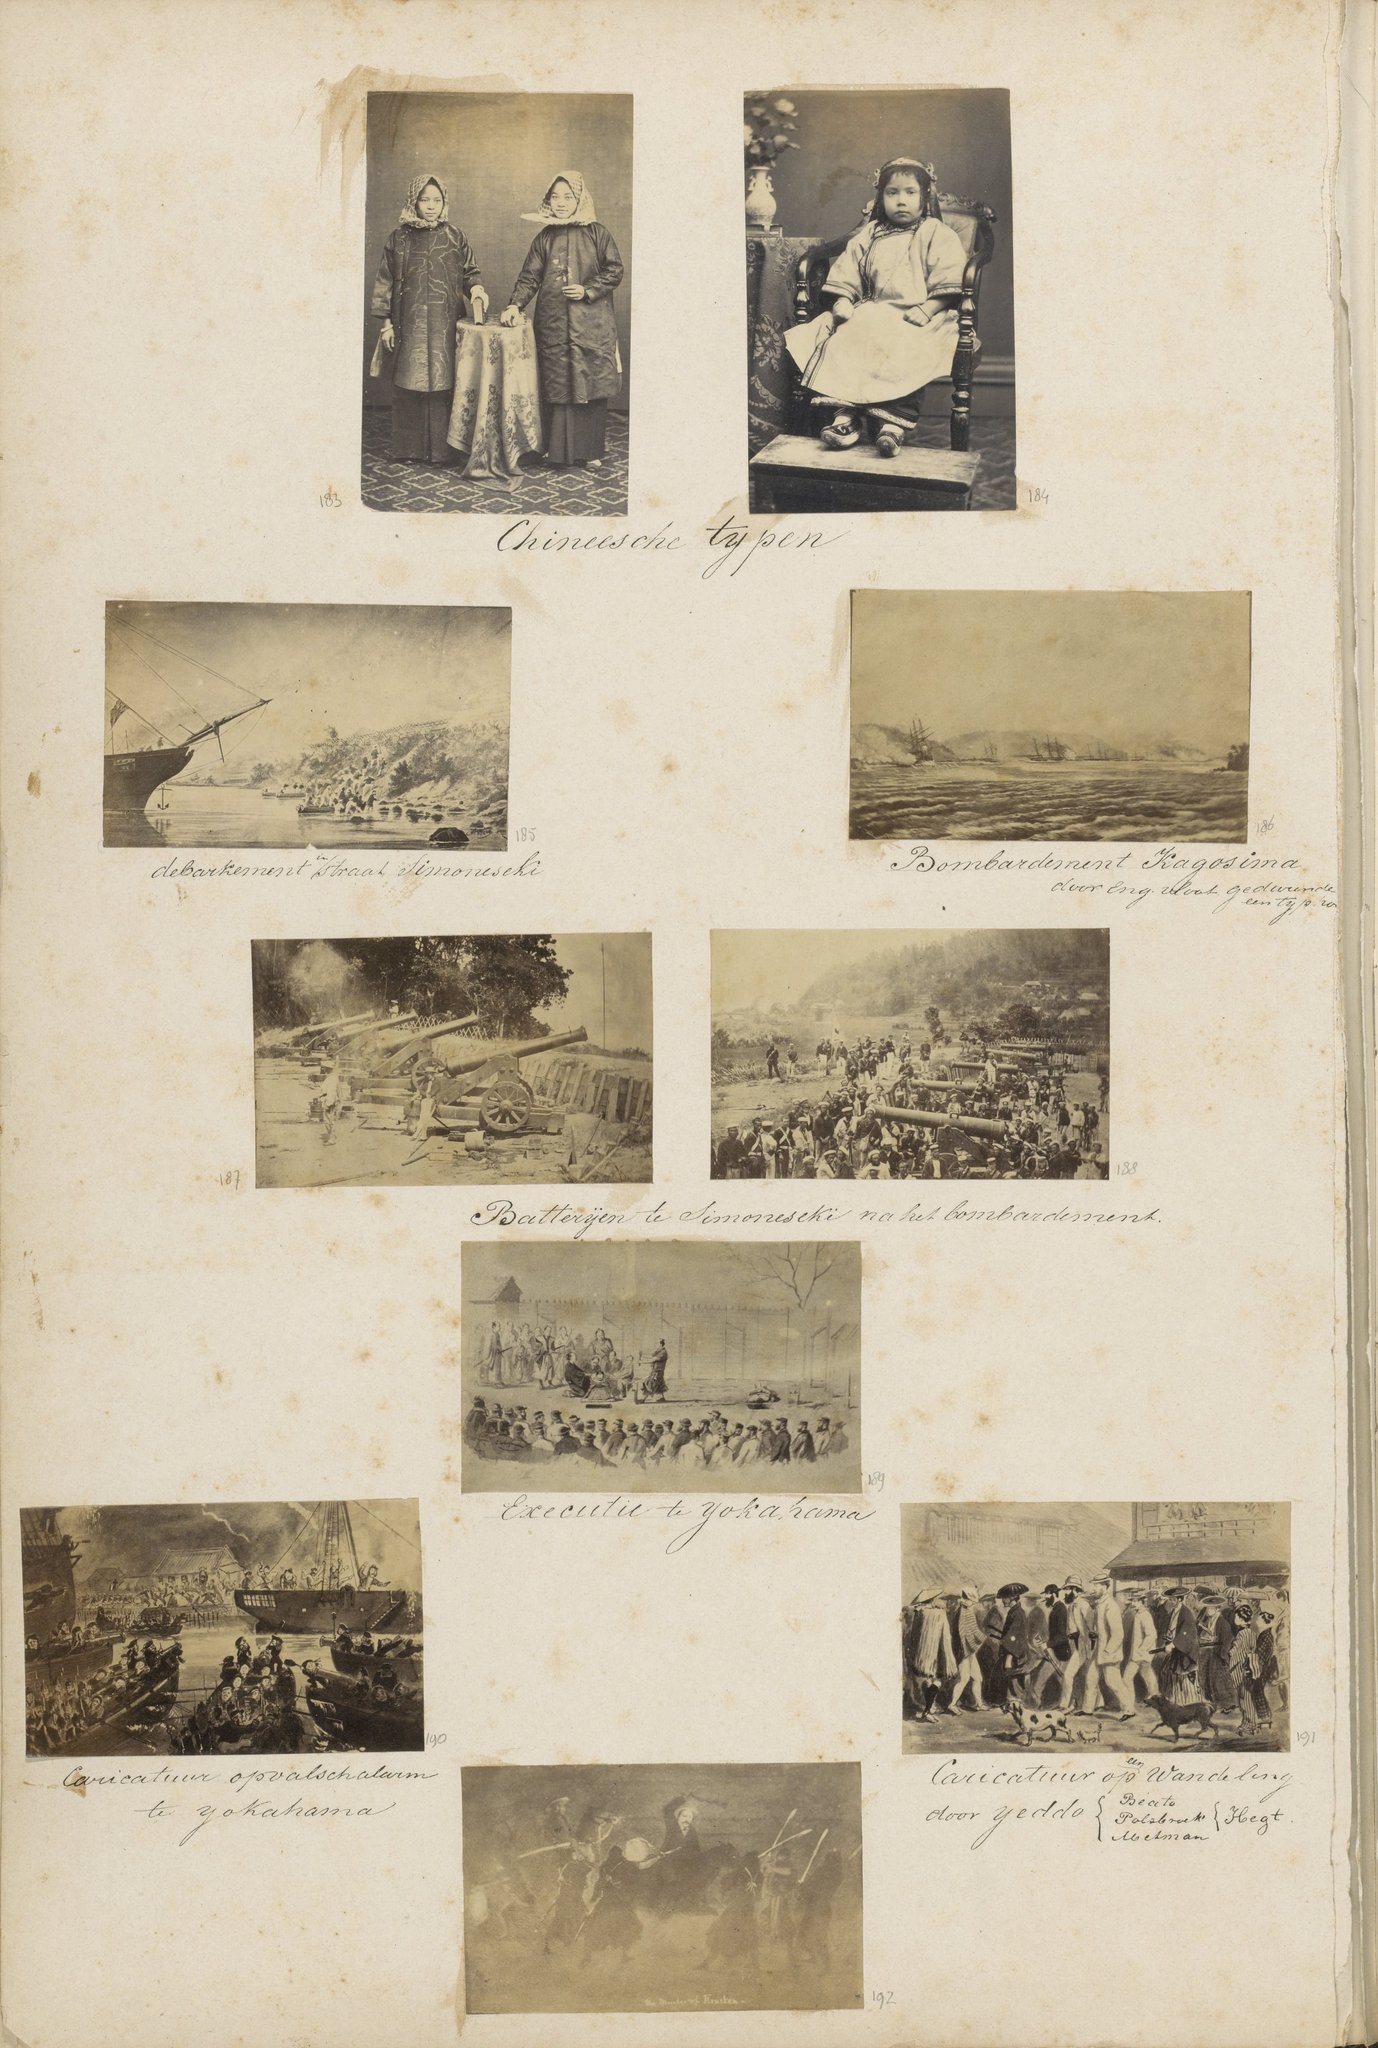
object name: photograph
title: Portret van een Chinees kind zittend in een fauteuil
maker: Anonymous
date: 1870-1880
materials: paper, photographic support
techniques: albumen print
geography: taiwan strait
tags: studio requisites ~ photographer, child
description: Onderdeel van Fotoalbum van Robert Daniel Crommelin (1841-1907).